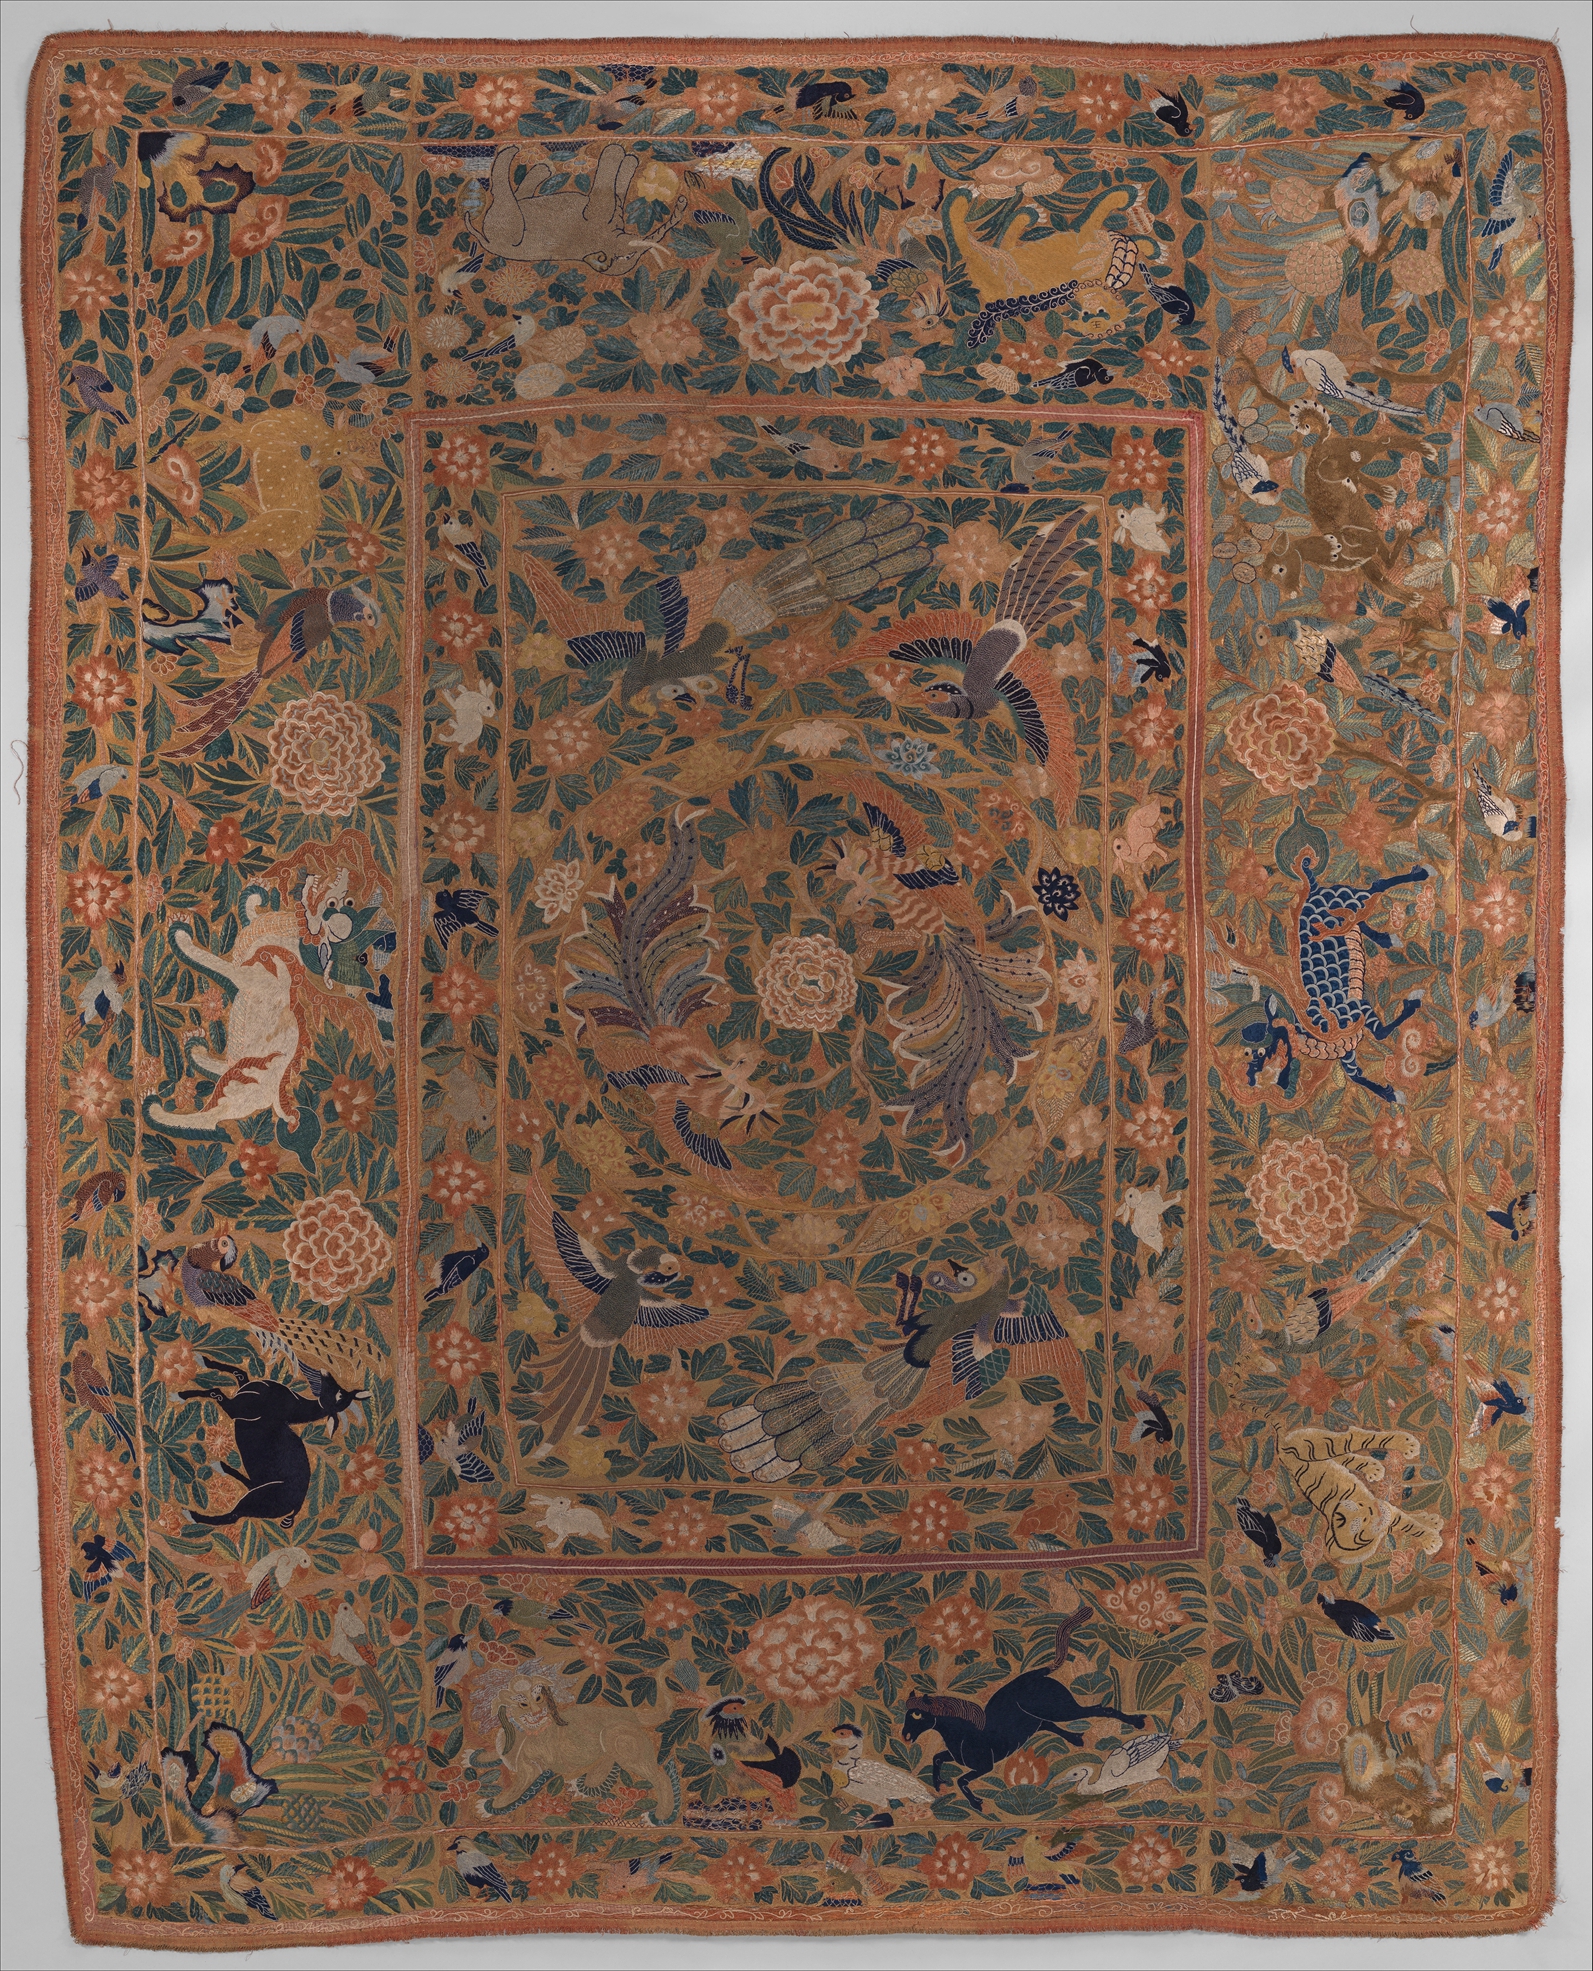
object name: panel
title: Panel with flowers, birds, and animals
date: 1601-1700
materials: gilt, paper, silk, thread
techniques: embroidery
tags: animals,birds,flowers